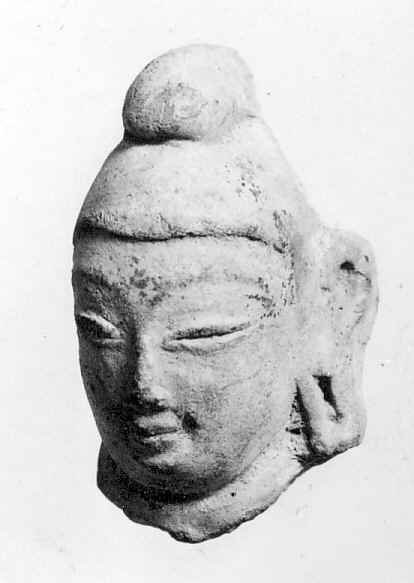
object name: head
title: Head of a Bodhisattva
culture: central asian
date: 1101-1133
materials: clay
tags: heads,buddhism,bodhisattvas